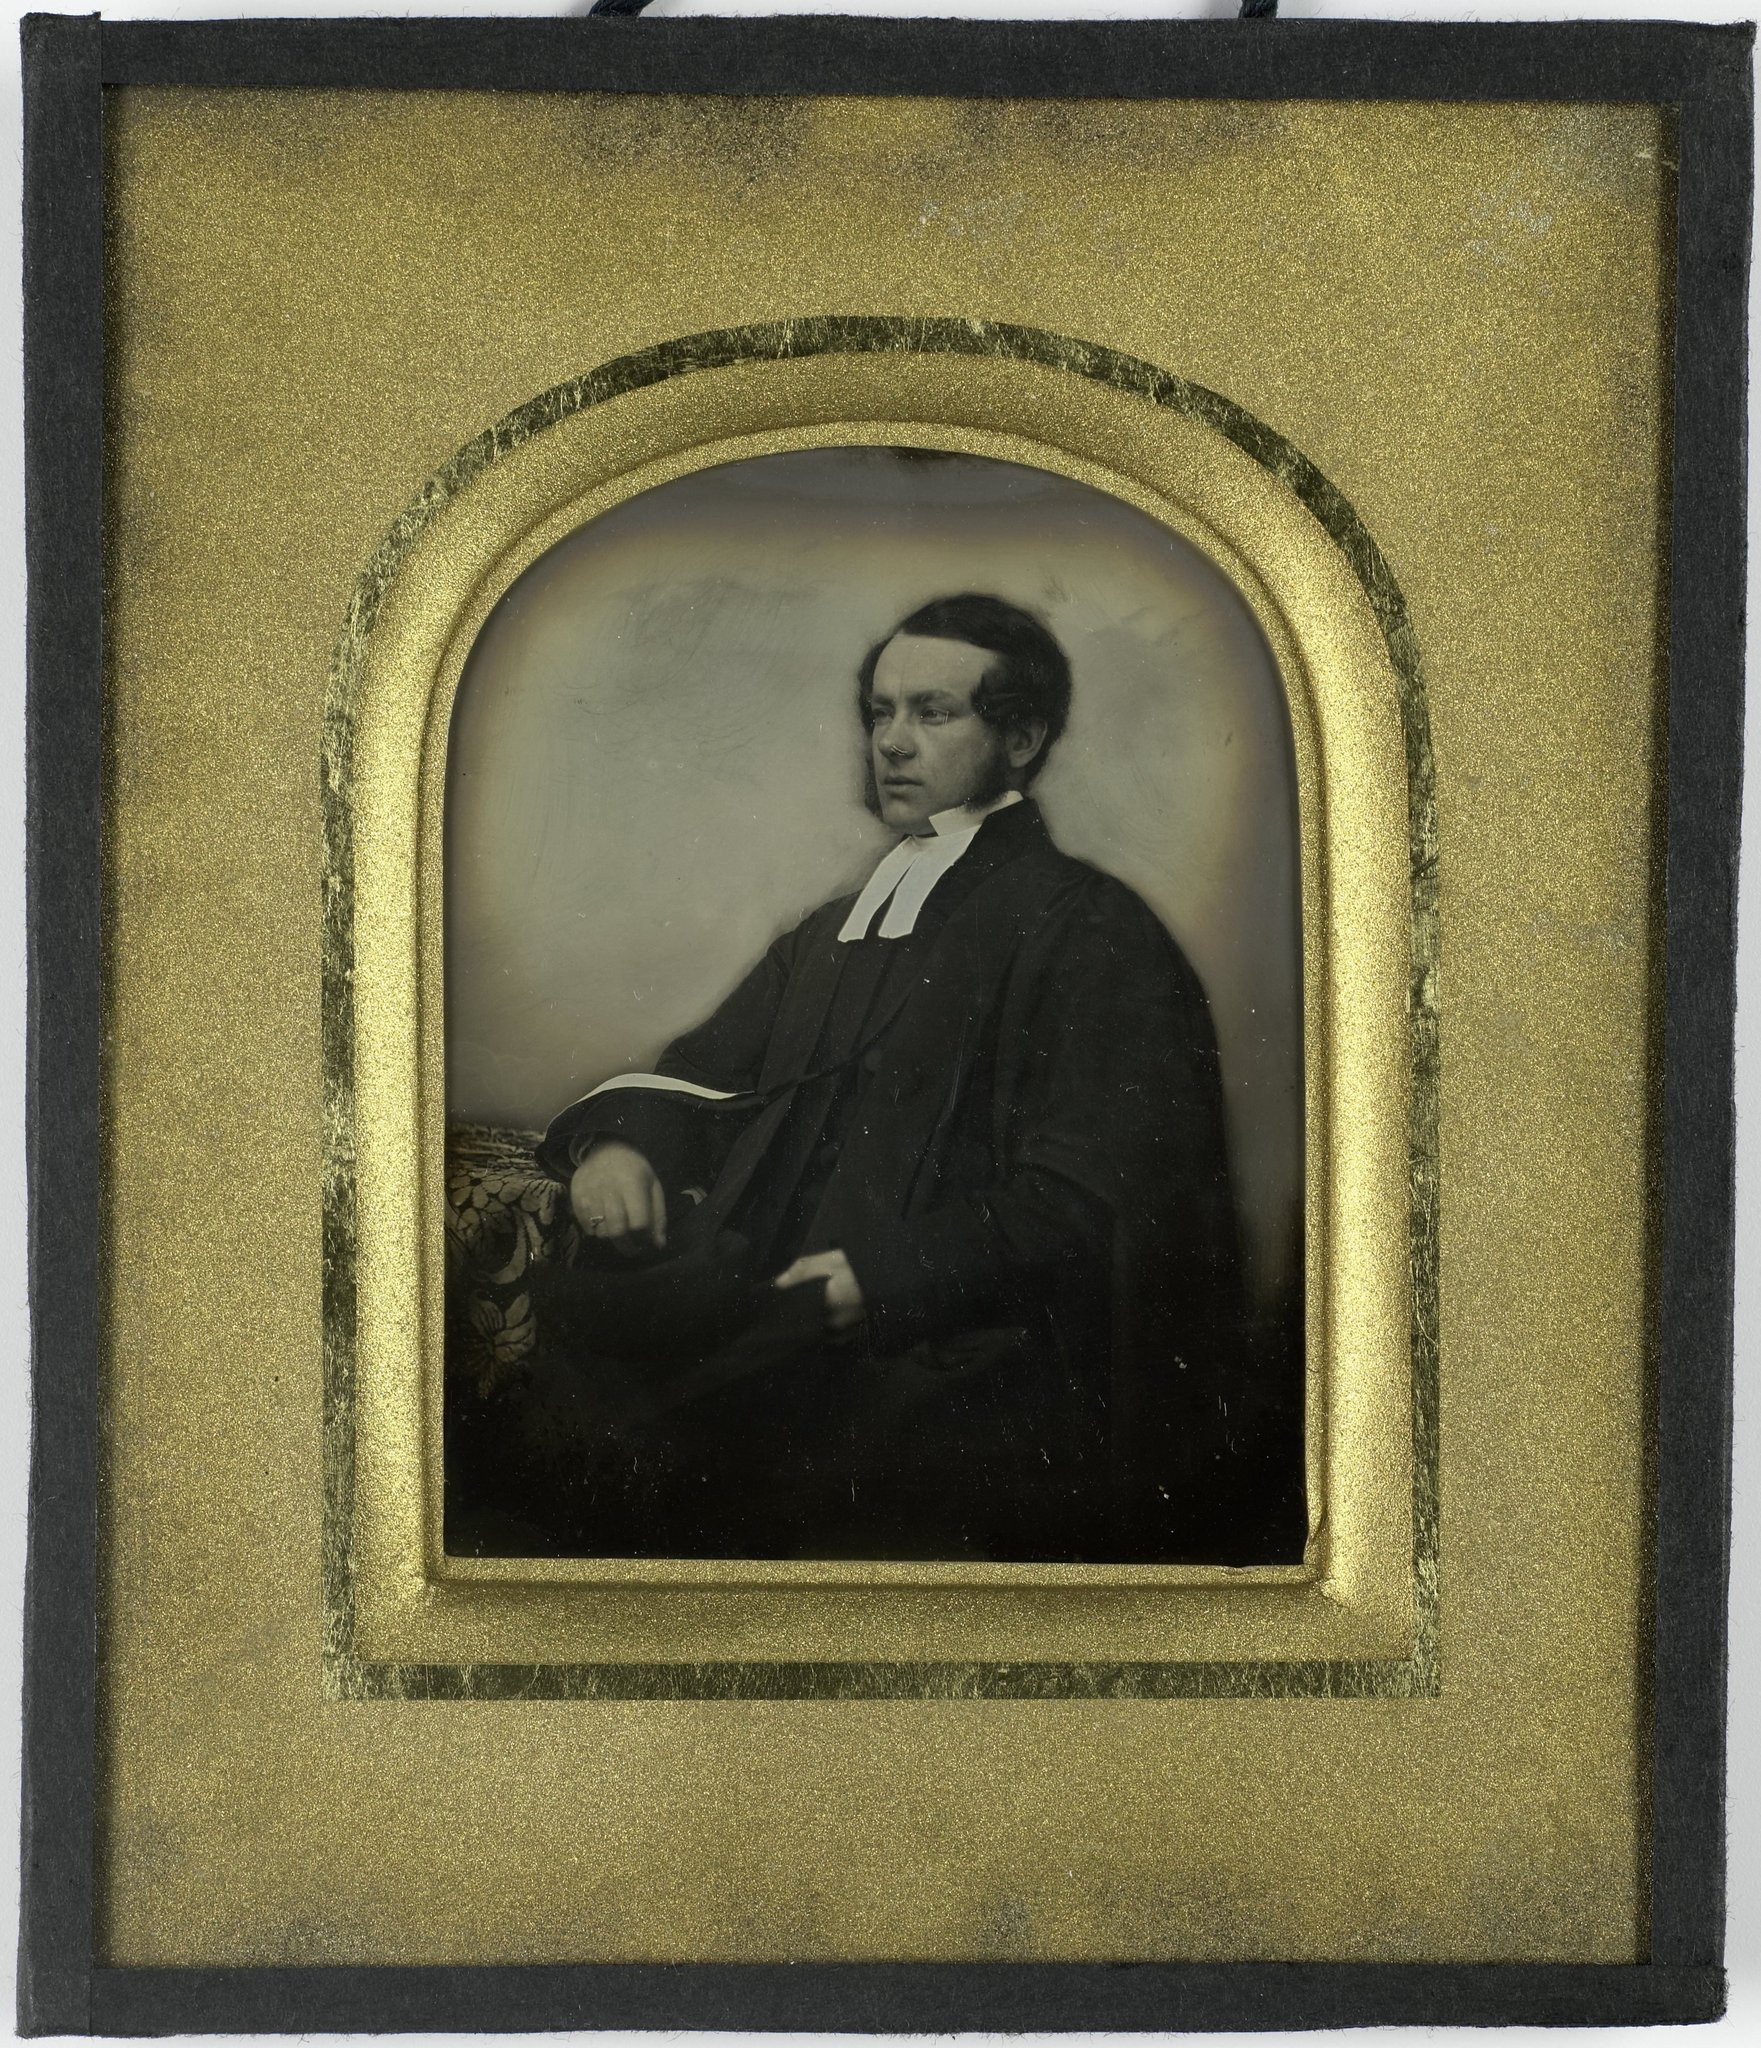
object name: photograph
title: Portret van een onbekende predikant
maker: Anonymous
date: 1855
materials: copper, glass, paper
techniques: daguerreotype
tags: adult man, historical persons